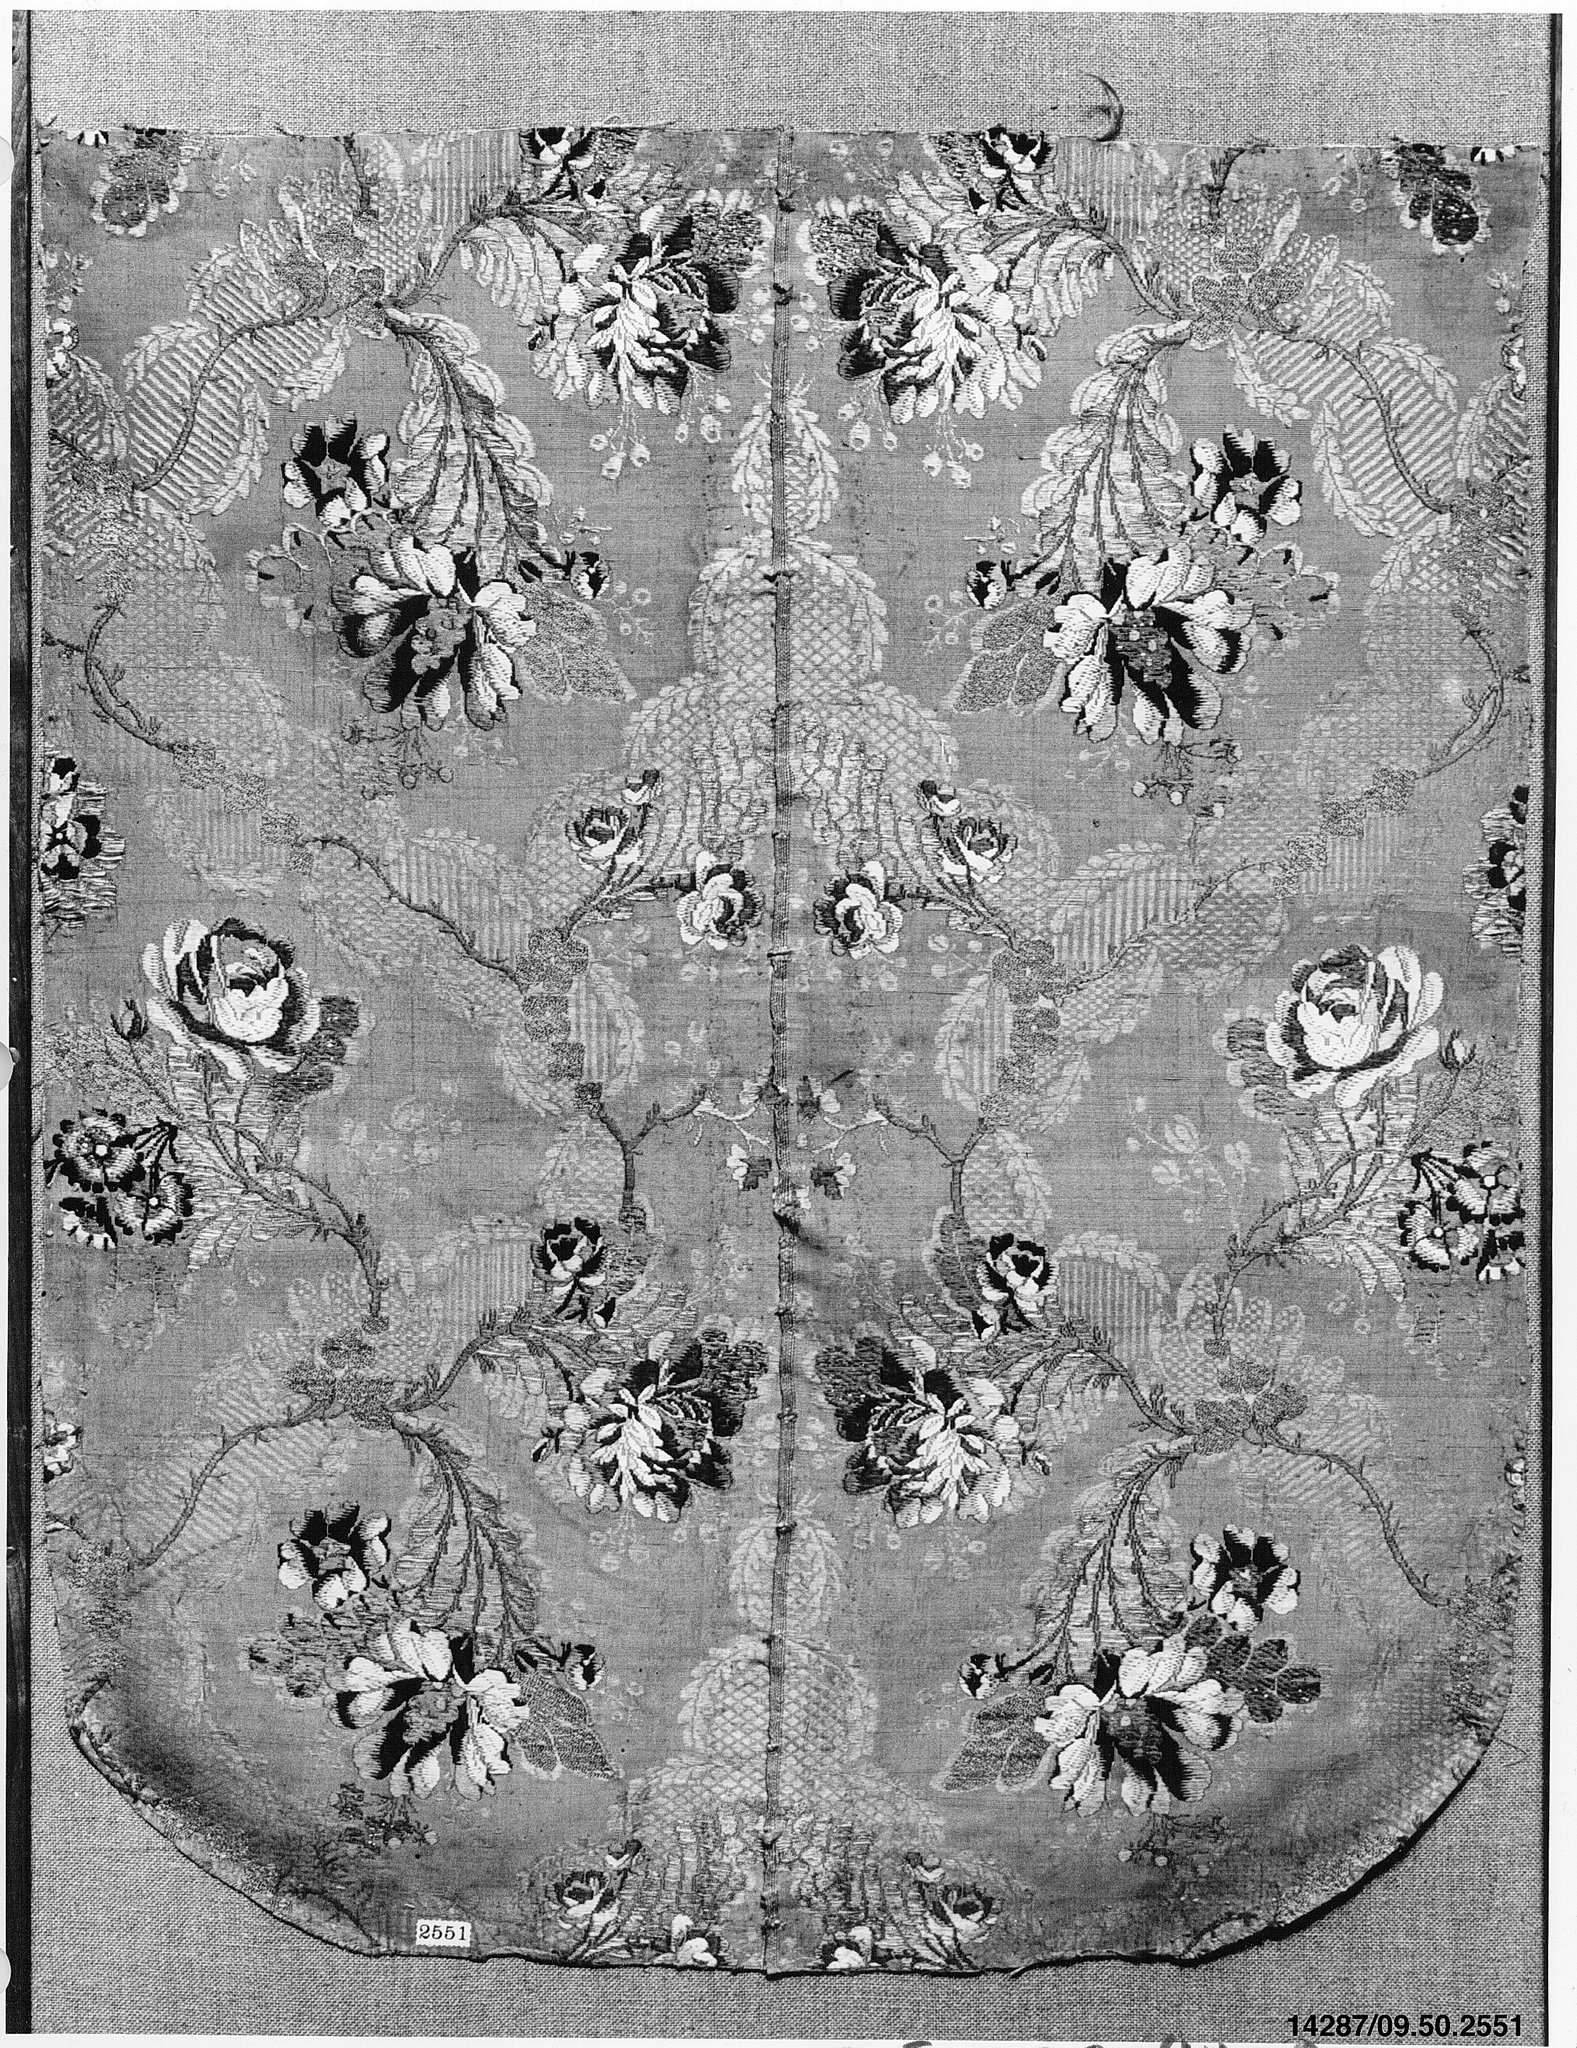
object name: piece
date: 1750-1760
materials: metal thread, silk